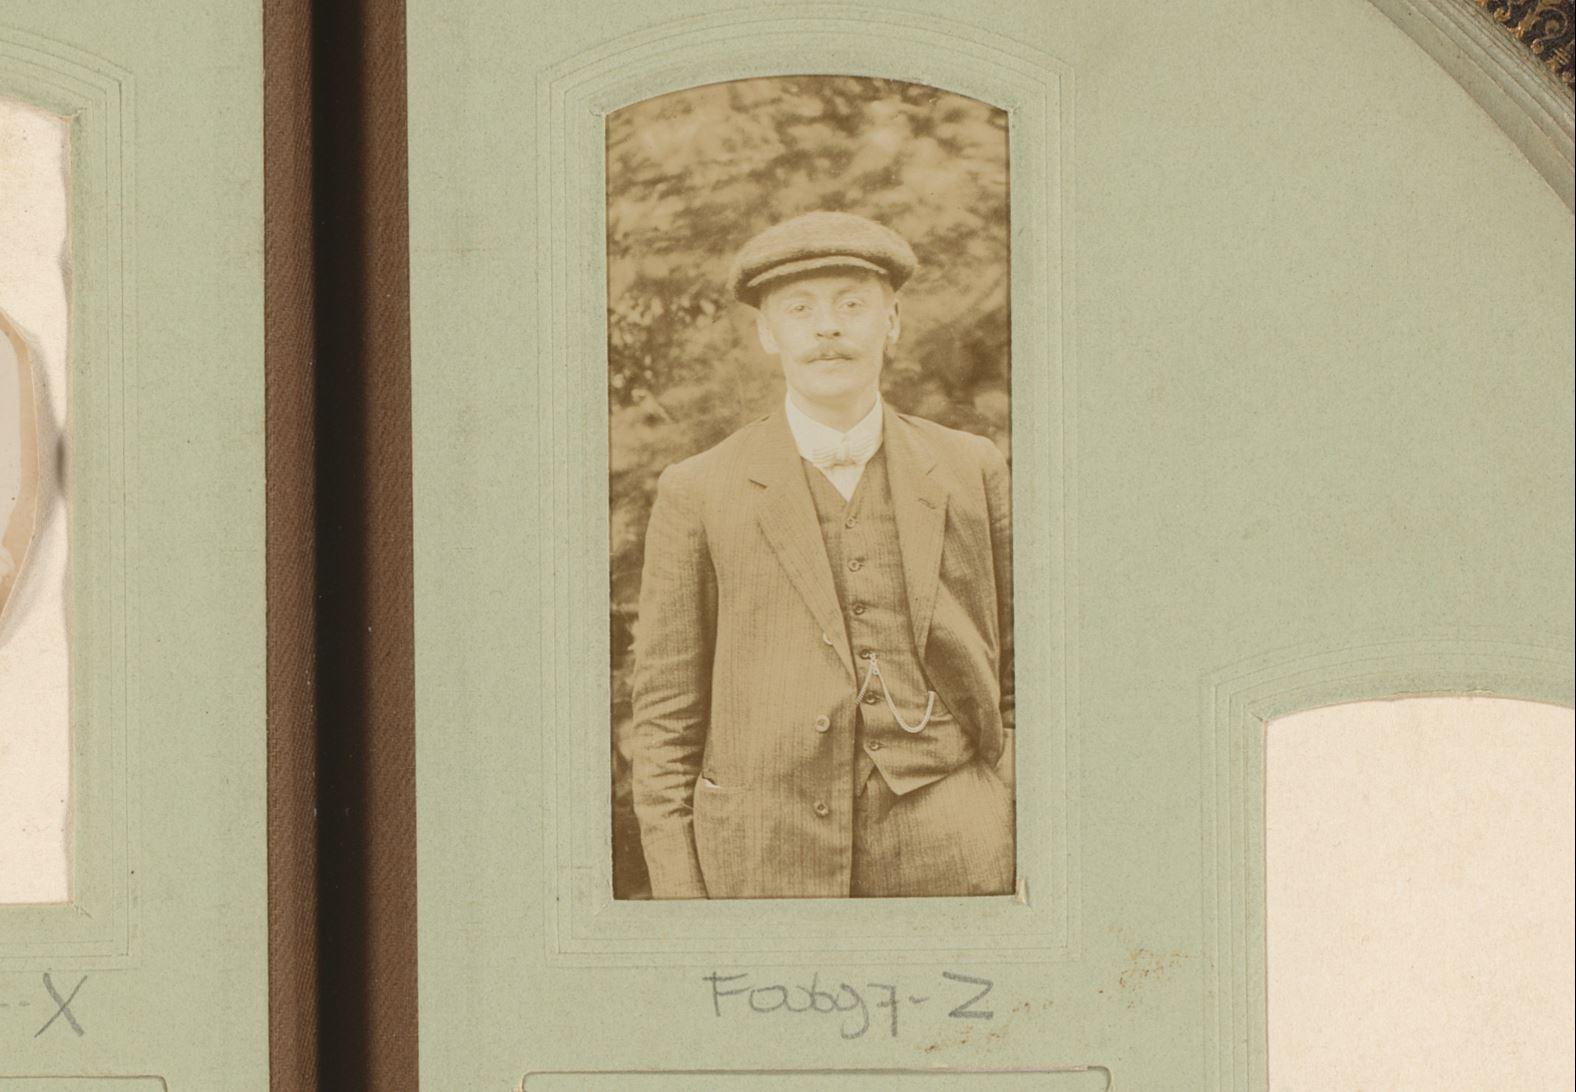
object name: album leaf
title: Portret van een man met een pet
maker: Anonymous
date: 1890-1915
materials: photographic support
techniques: gelatin silver print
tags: adult man, historical persons, head-gear: cap